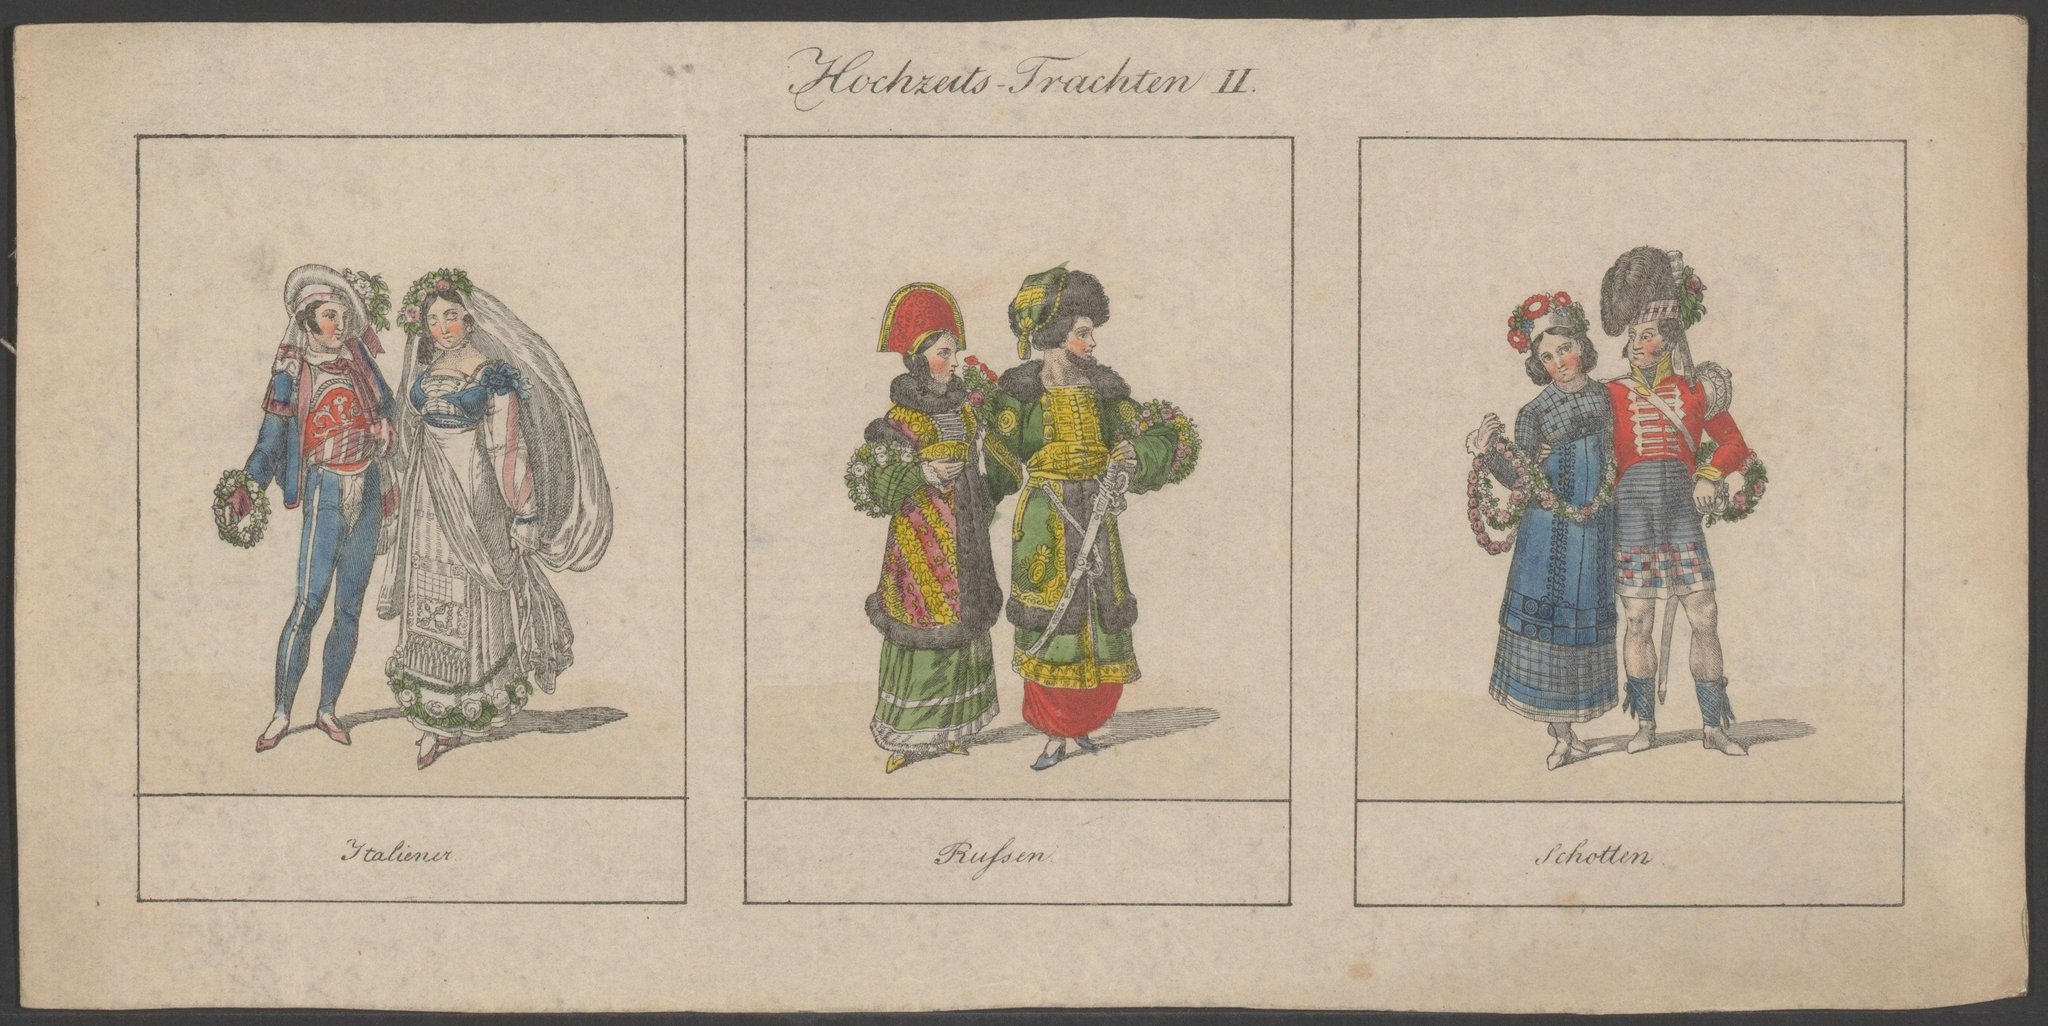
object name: popular print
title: Drie stellen in traditionele kostuums van Italianen, Russen en Schotten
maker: Anonymous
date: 1815-1858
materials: paper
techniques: engraving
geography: dusseldorf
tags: folk costume, regional costume, italy, russia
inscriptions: stamp, collector's mark: Lugt 1641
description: Onderwerpsrubrieken binnen de Atlas Zeden en Gewoonten: Zeden en gewoonten in engeren zin, Des menschen begin, midden en einde, Kinderprenten opgeplakt op karton.